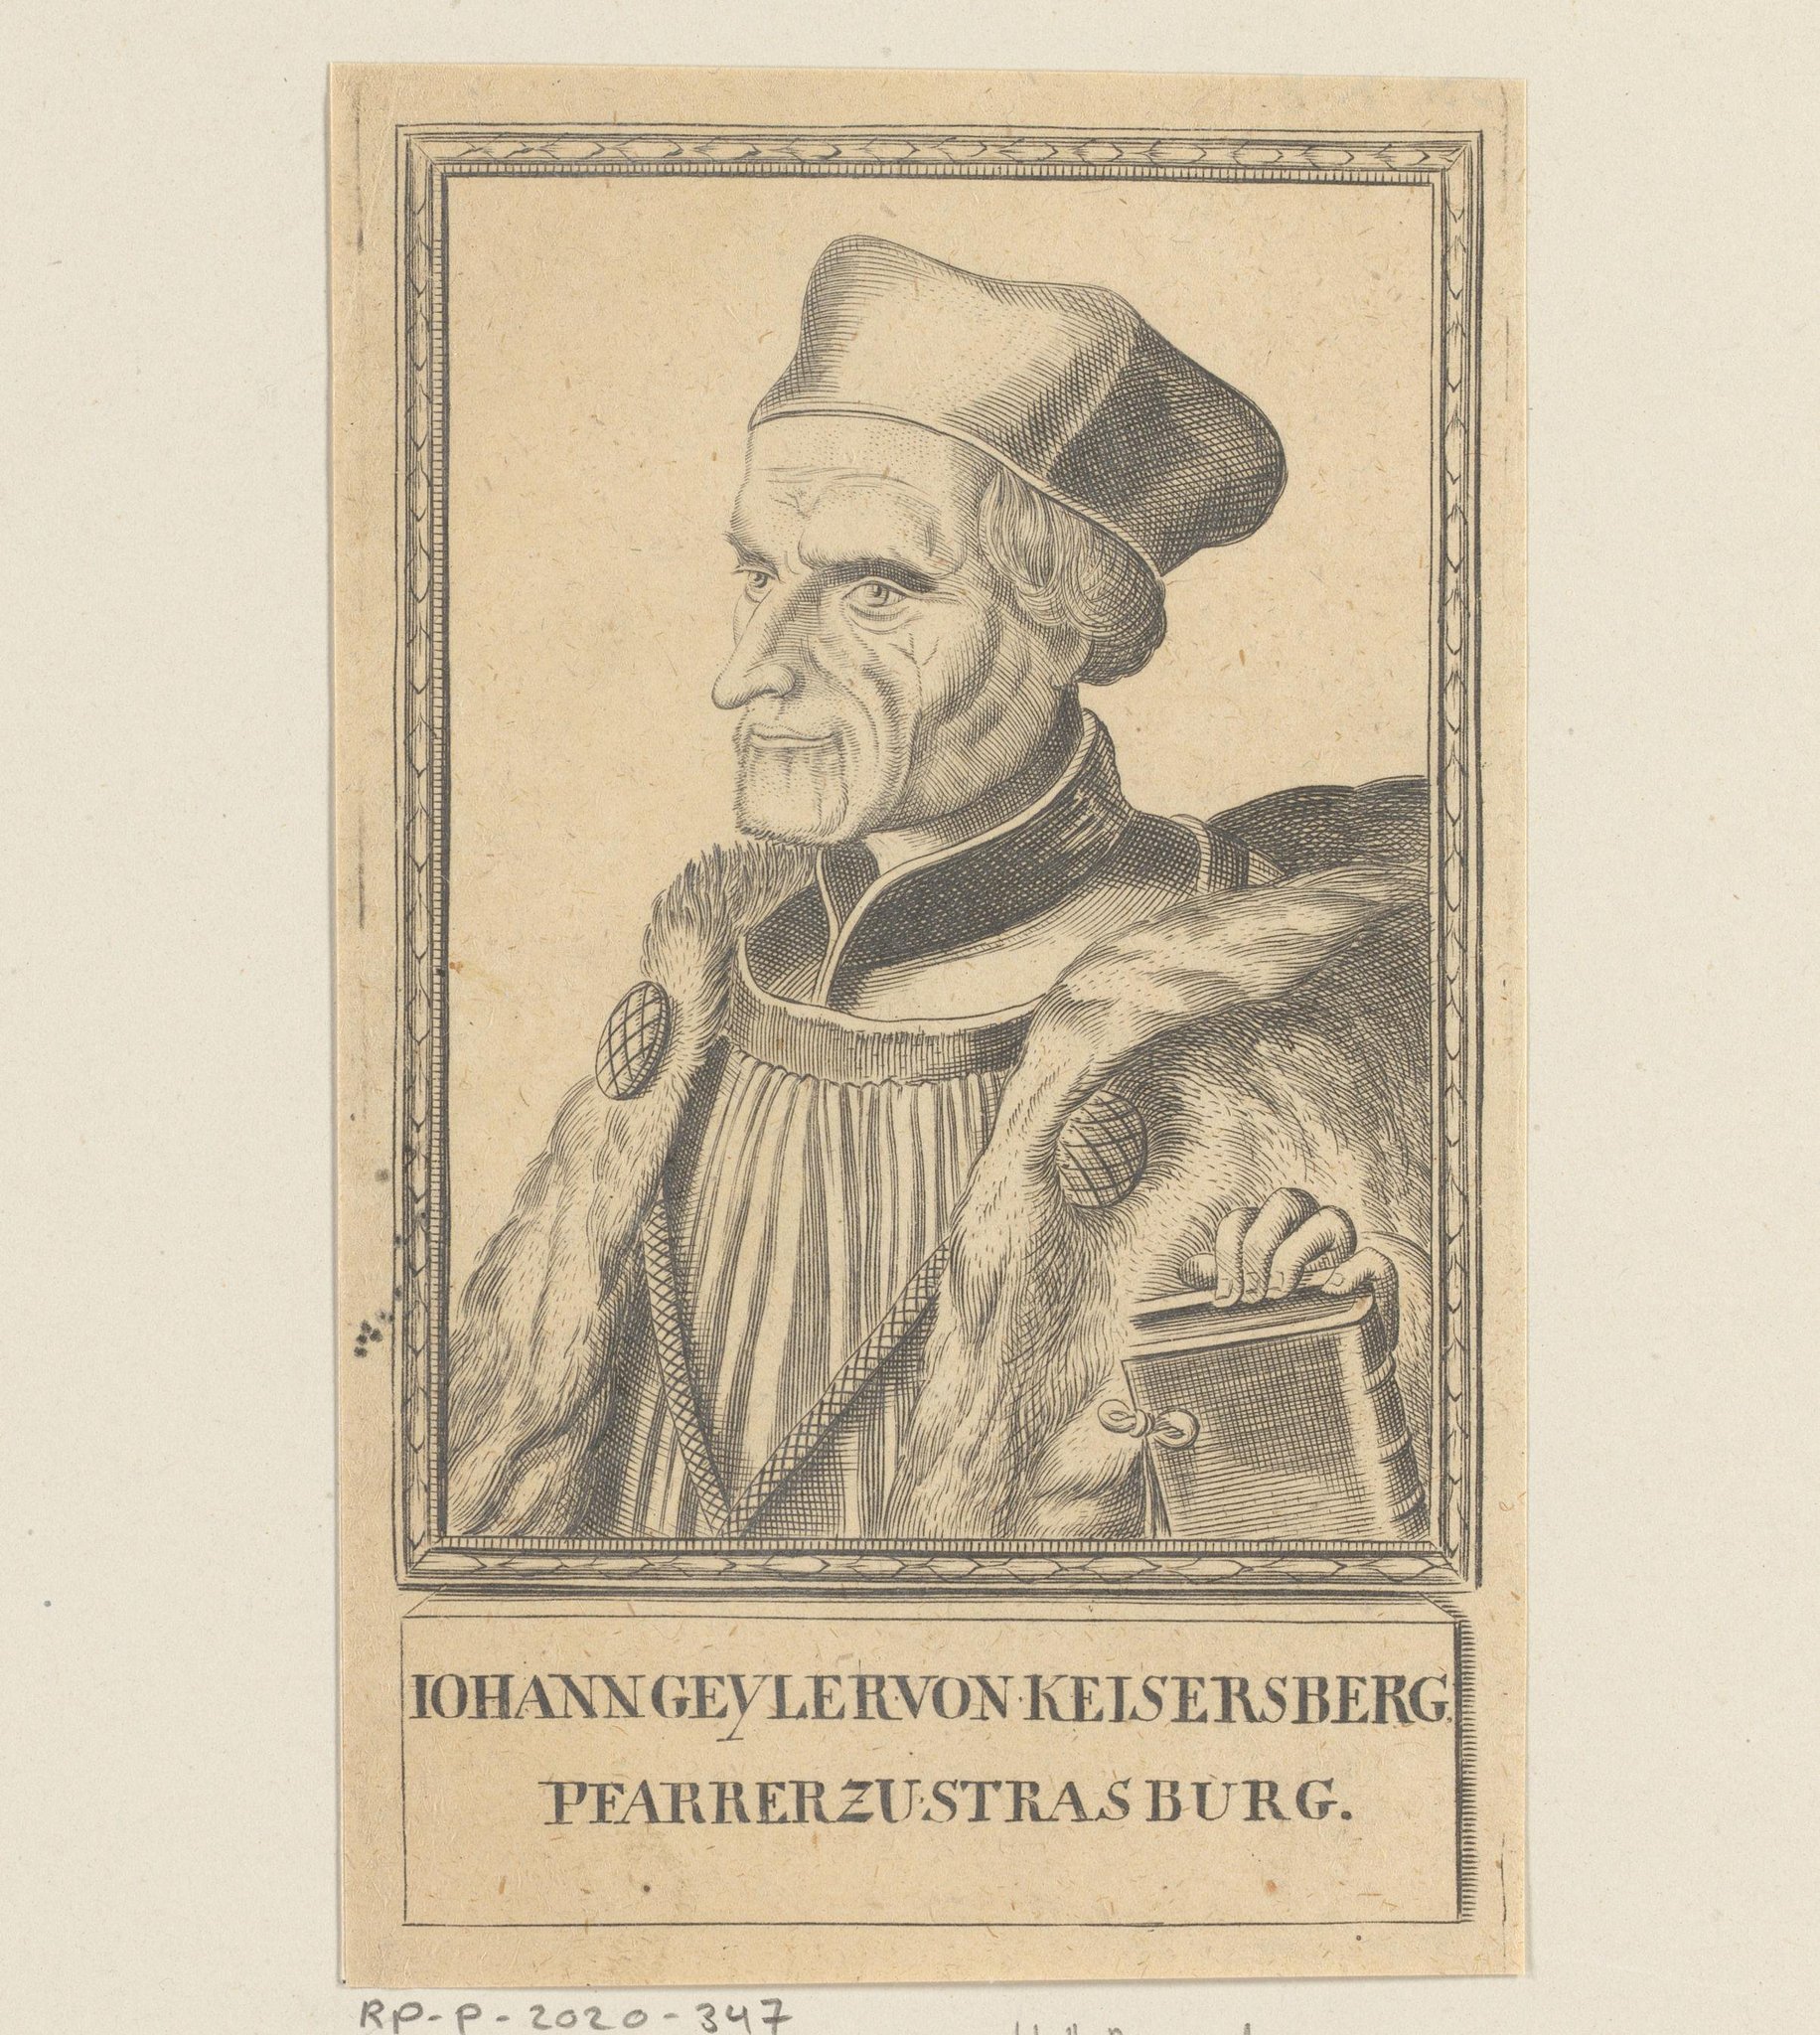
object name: print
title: Portret van Johann Geiler von Kaisersberg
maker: Anonymous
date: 1721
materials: paper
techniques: engraving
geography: leipzig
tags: priest (roman catholic), historical persons, book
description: Prent uit: Fortgesetzte Sammlung Von Alten und Neuen Theologischen Sachen (...). Leipzig: erven Johann Friedrich Braun, 1721.